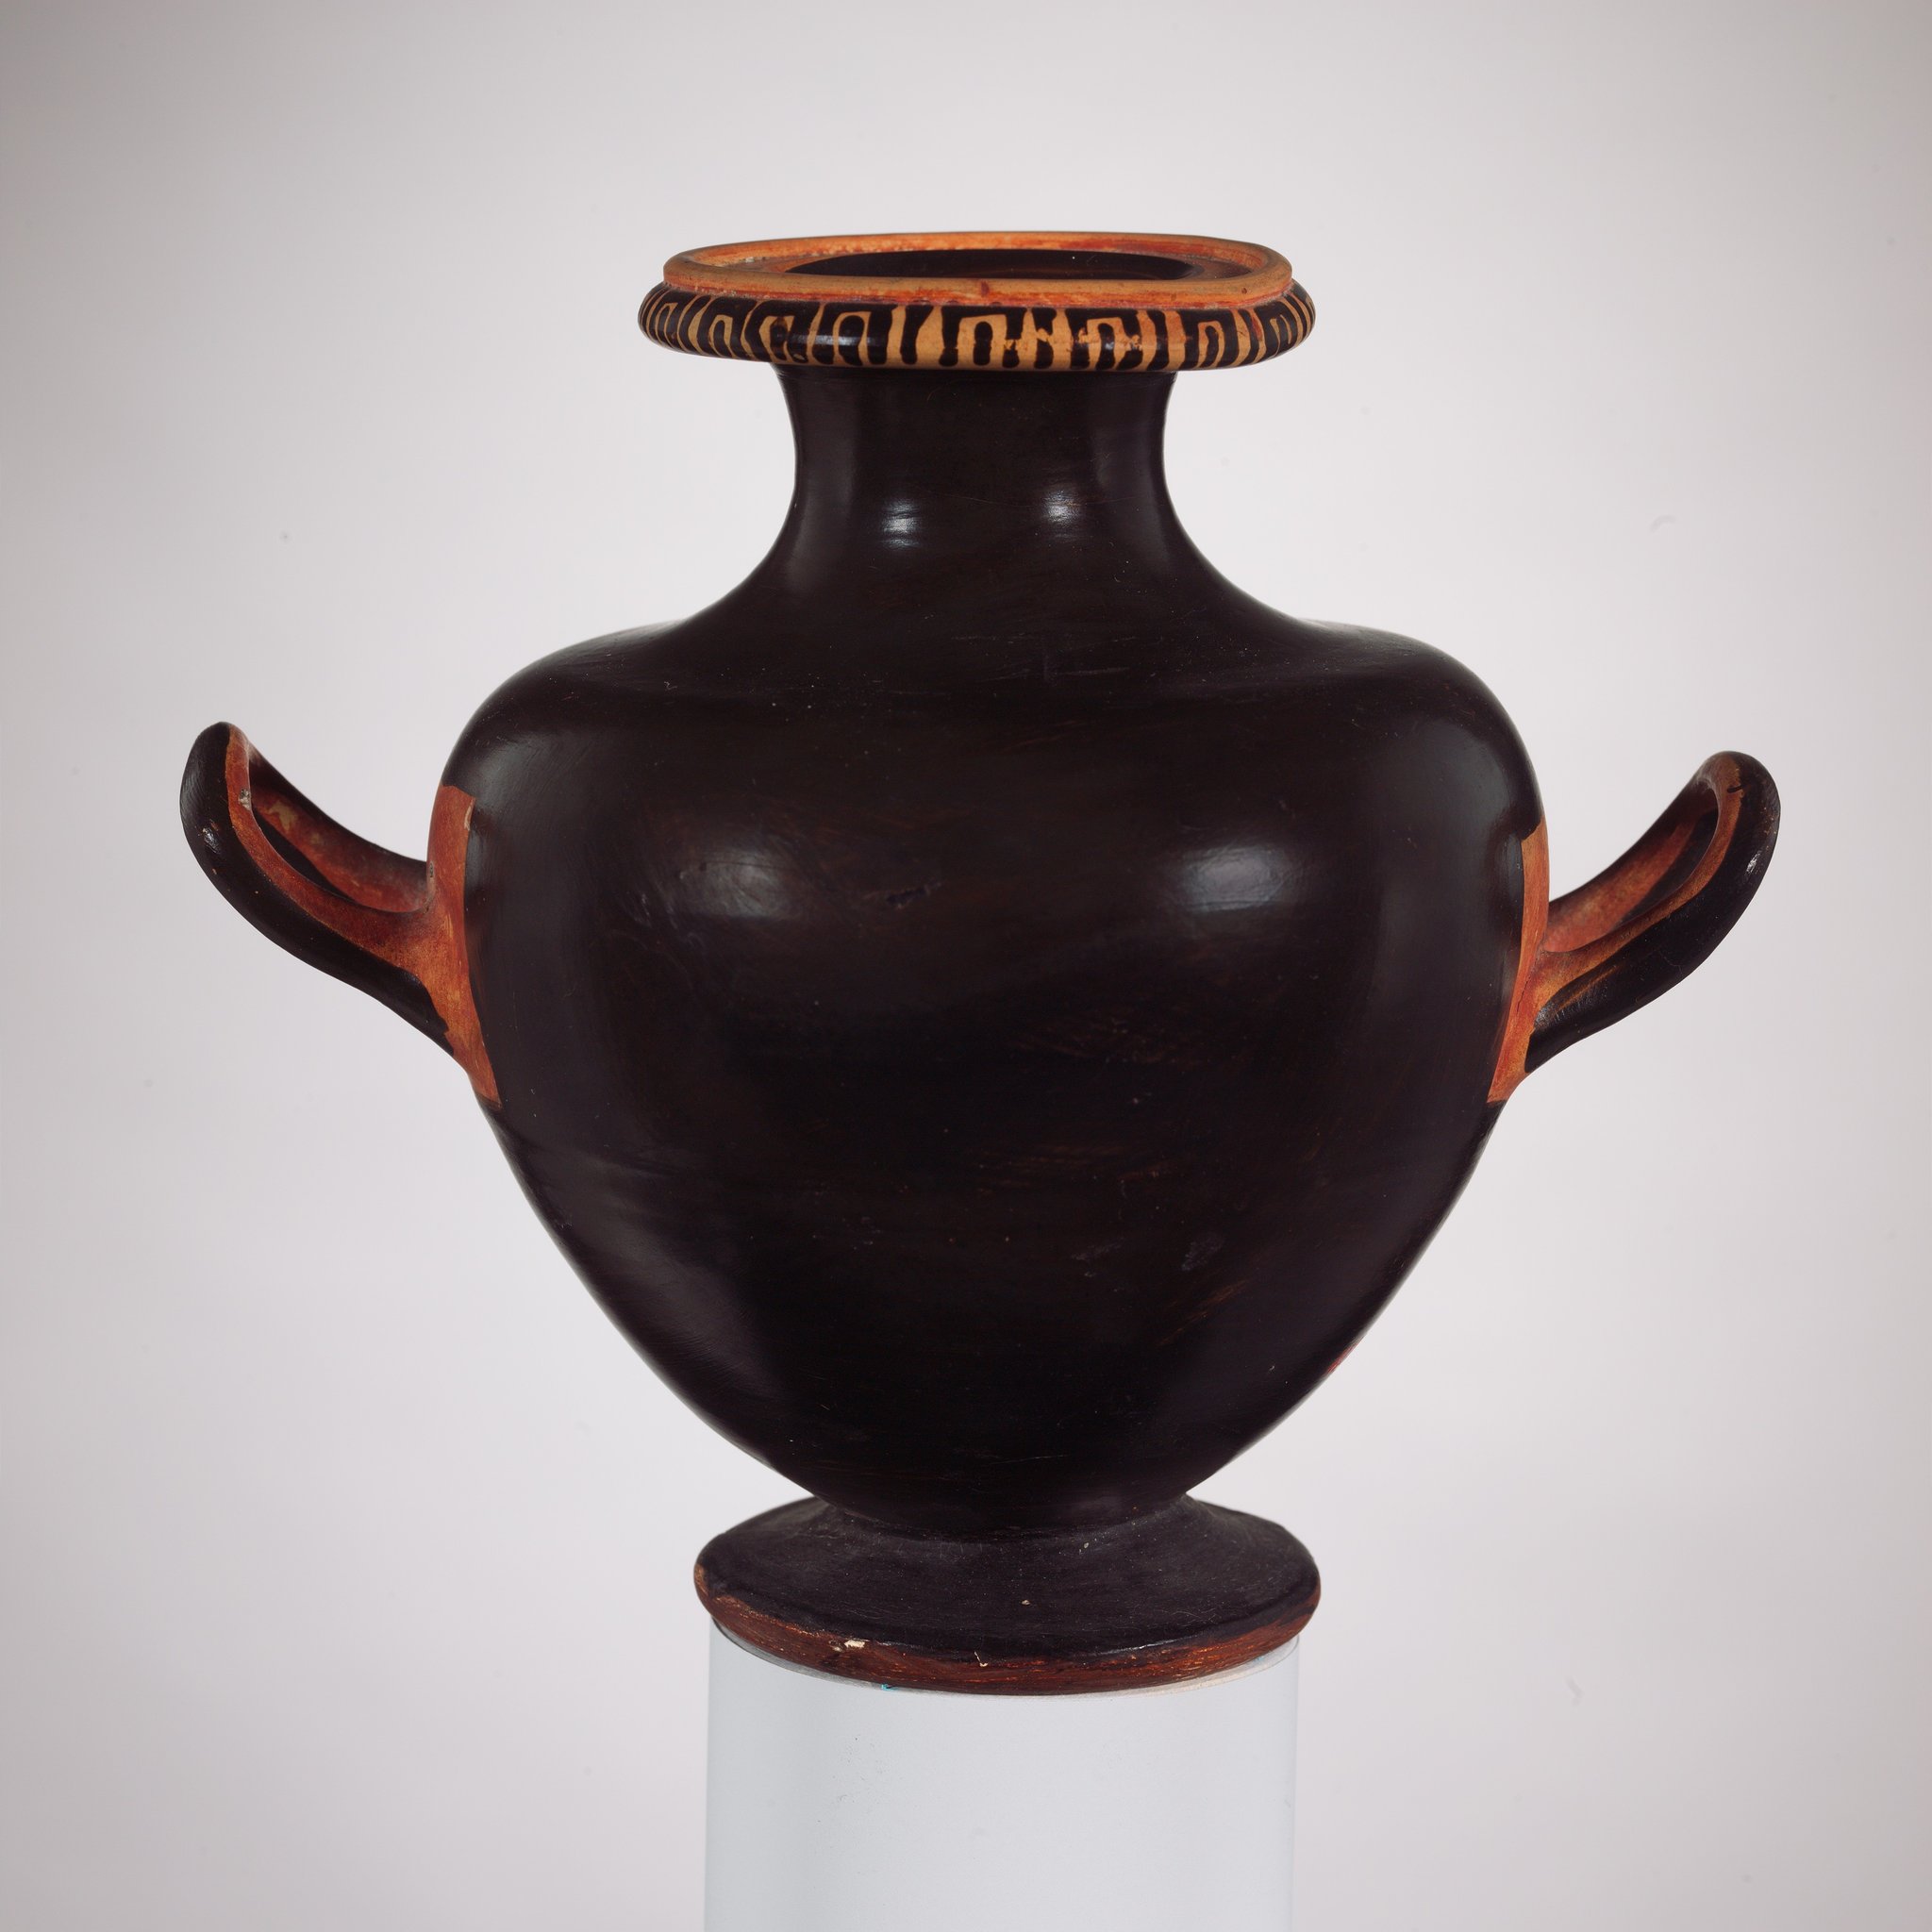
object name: hydria, kalpis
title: Terracotta hydria: kalpis (water jar)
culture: greek or south italian or campanian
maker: owl-pillar group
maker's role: artist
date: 434-401 BCE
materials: terracotta